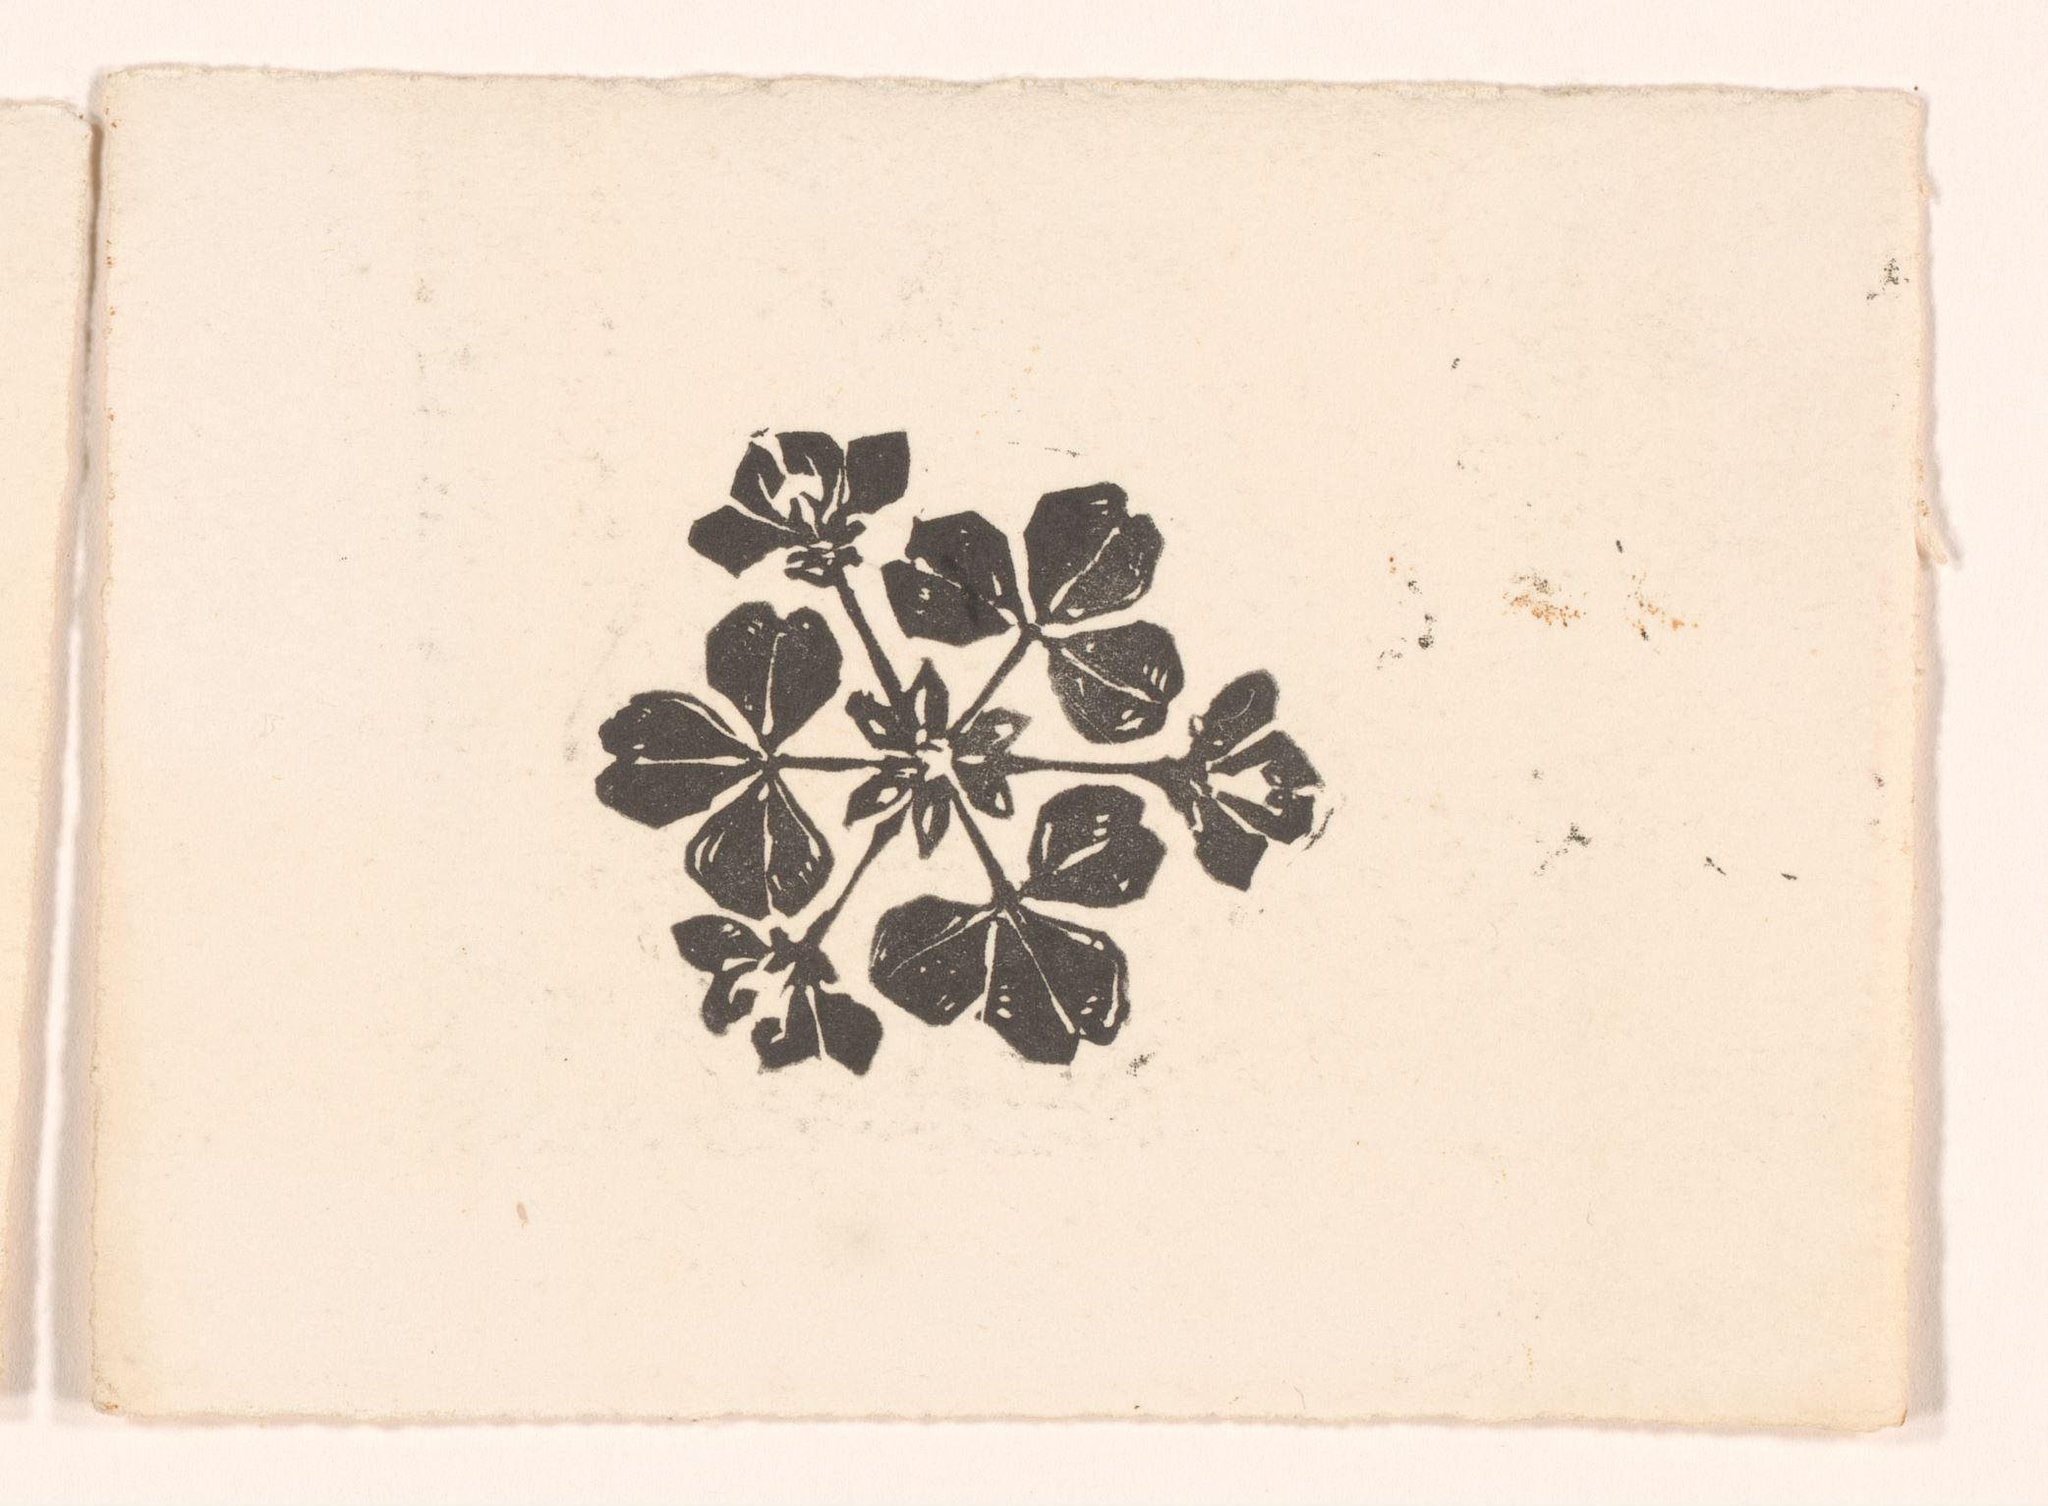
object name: boekillustratie ontwerp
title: Bloem vignet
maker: bernard willem wierink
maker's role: draughtsman, print maker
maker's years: 1856-1939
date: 1910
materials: paper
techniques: relief print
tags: flowers, fable of reynard the fox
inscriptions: collector's mark: Lugt 2228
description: Ontwerp voor: Streuvels, Stijn (Frank Lateur). Reinaert de Vos naar verschillende uitgaven van het middeleeuwsche epos. Amsterdam: L.J. Veen, 1910. Deze prent is vermoedelijk een plaatsnede, ook al wordt in de literatuur veelal gesproken over een houtsnede. Voor zover Wierink zijn prenten in hoogdruk zelf nader heeft omschreven, heeft hij altijd de term 'plaatsnede' gebruikt.